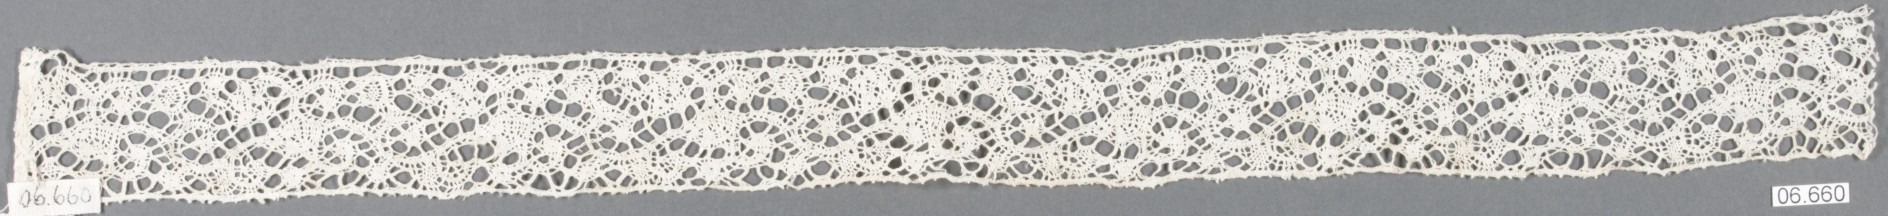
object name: strip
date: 1700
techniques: lace